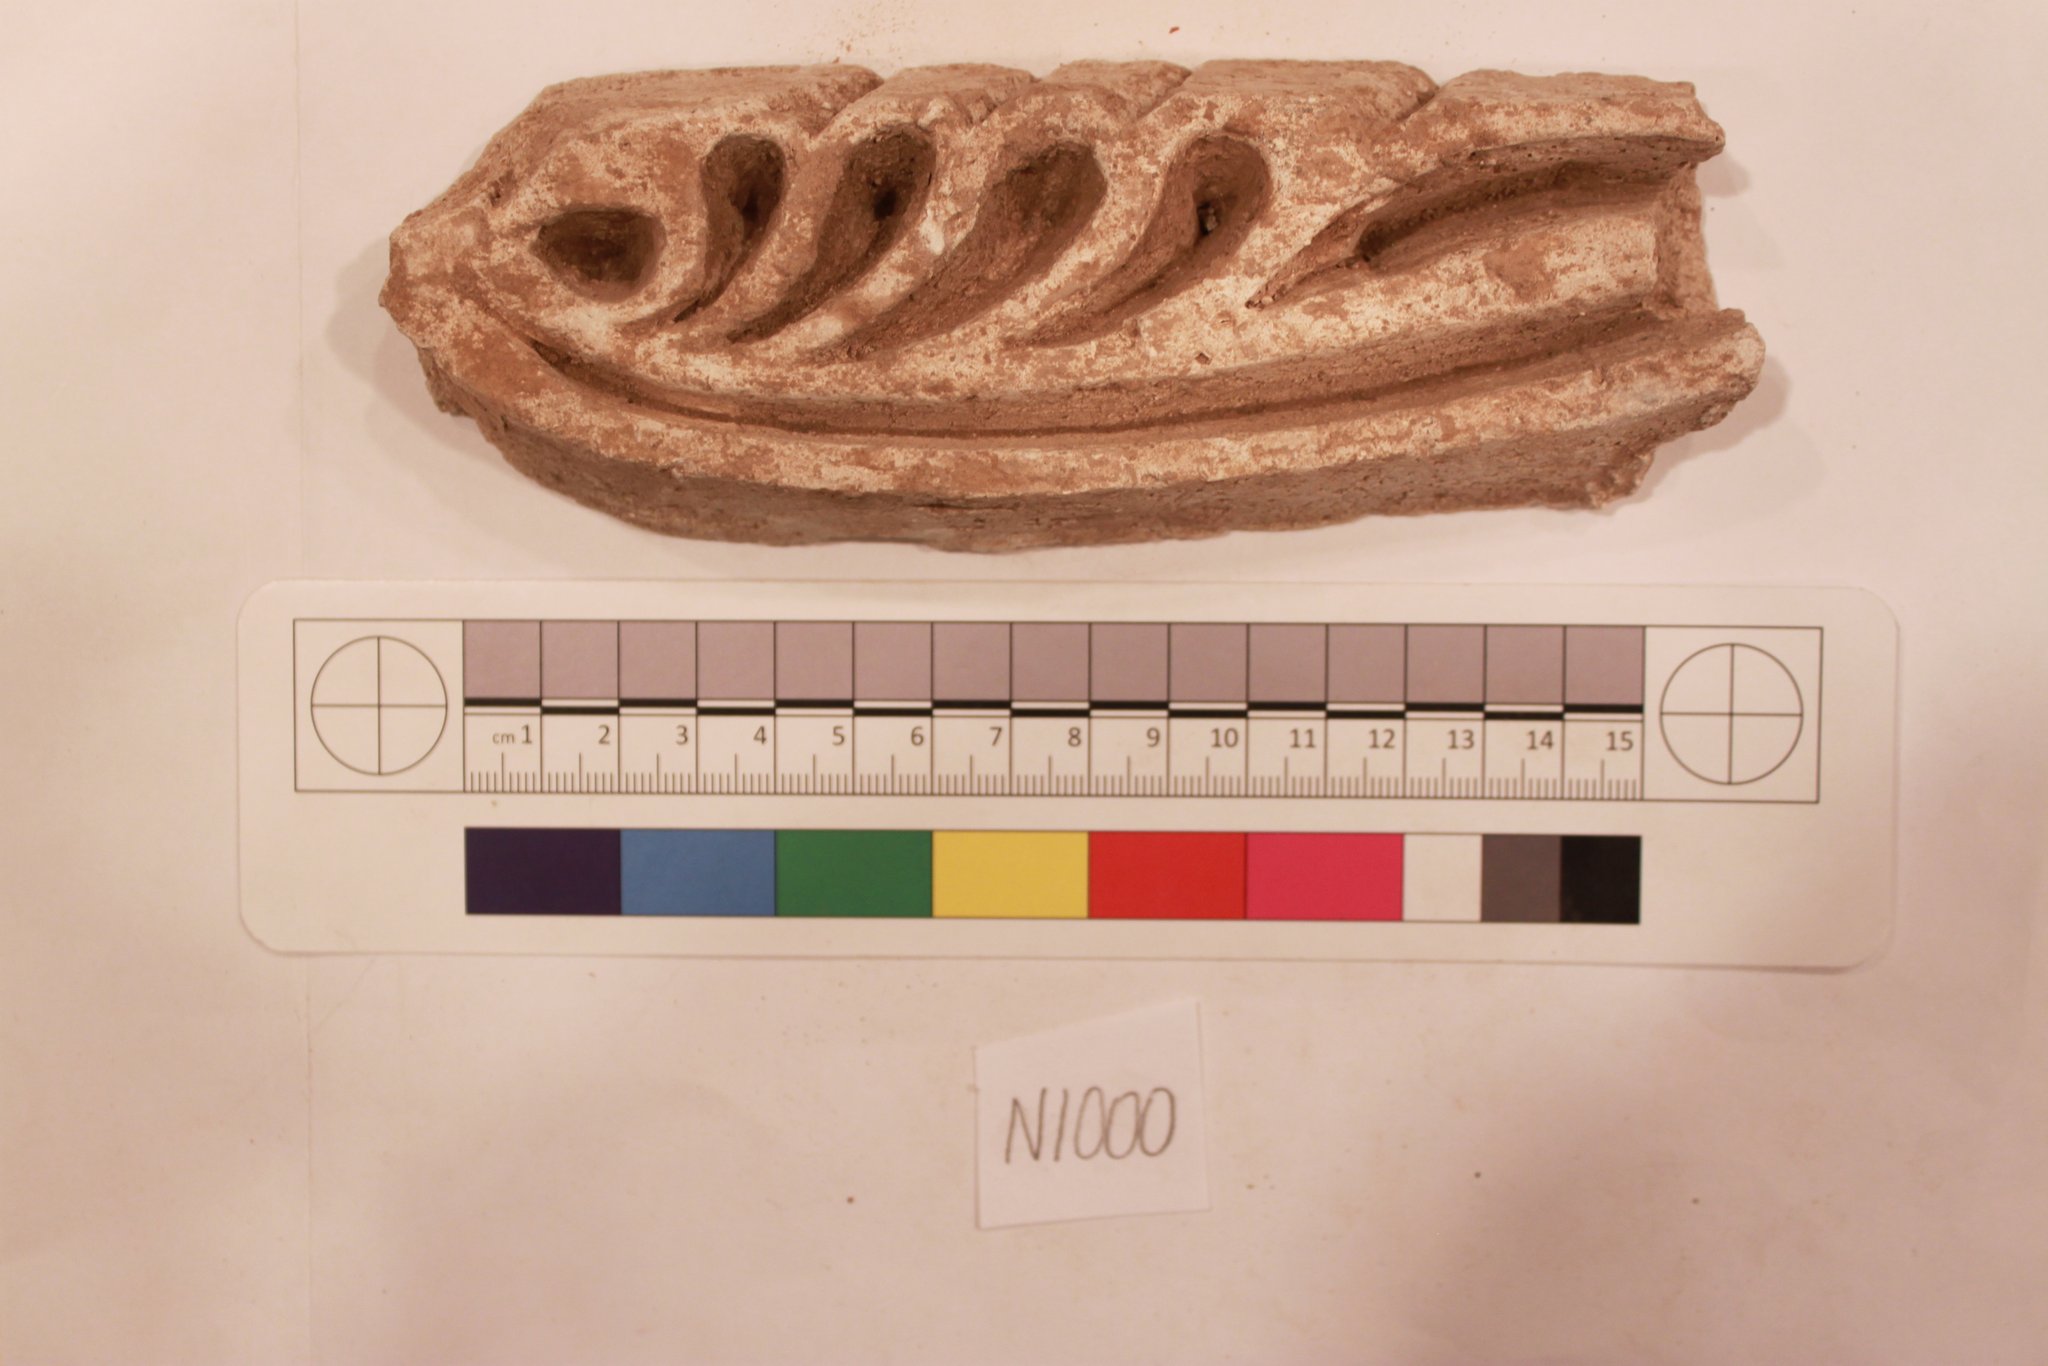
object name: fragment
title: Stucco Fragment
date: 701-1200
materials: plaster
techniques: carving, painting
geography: iran